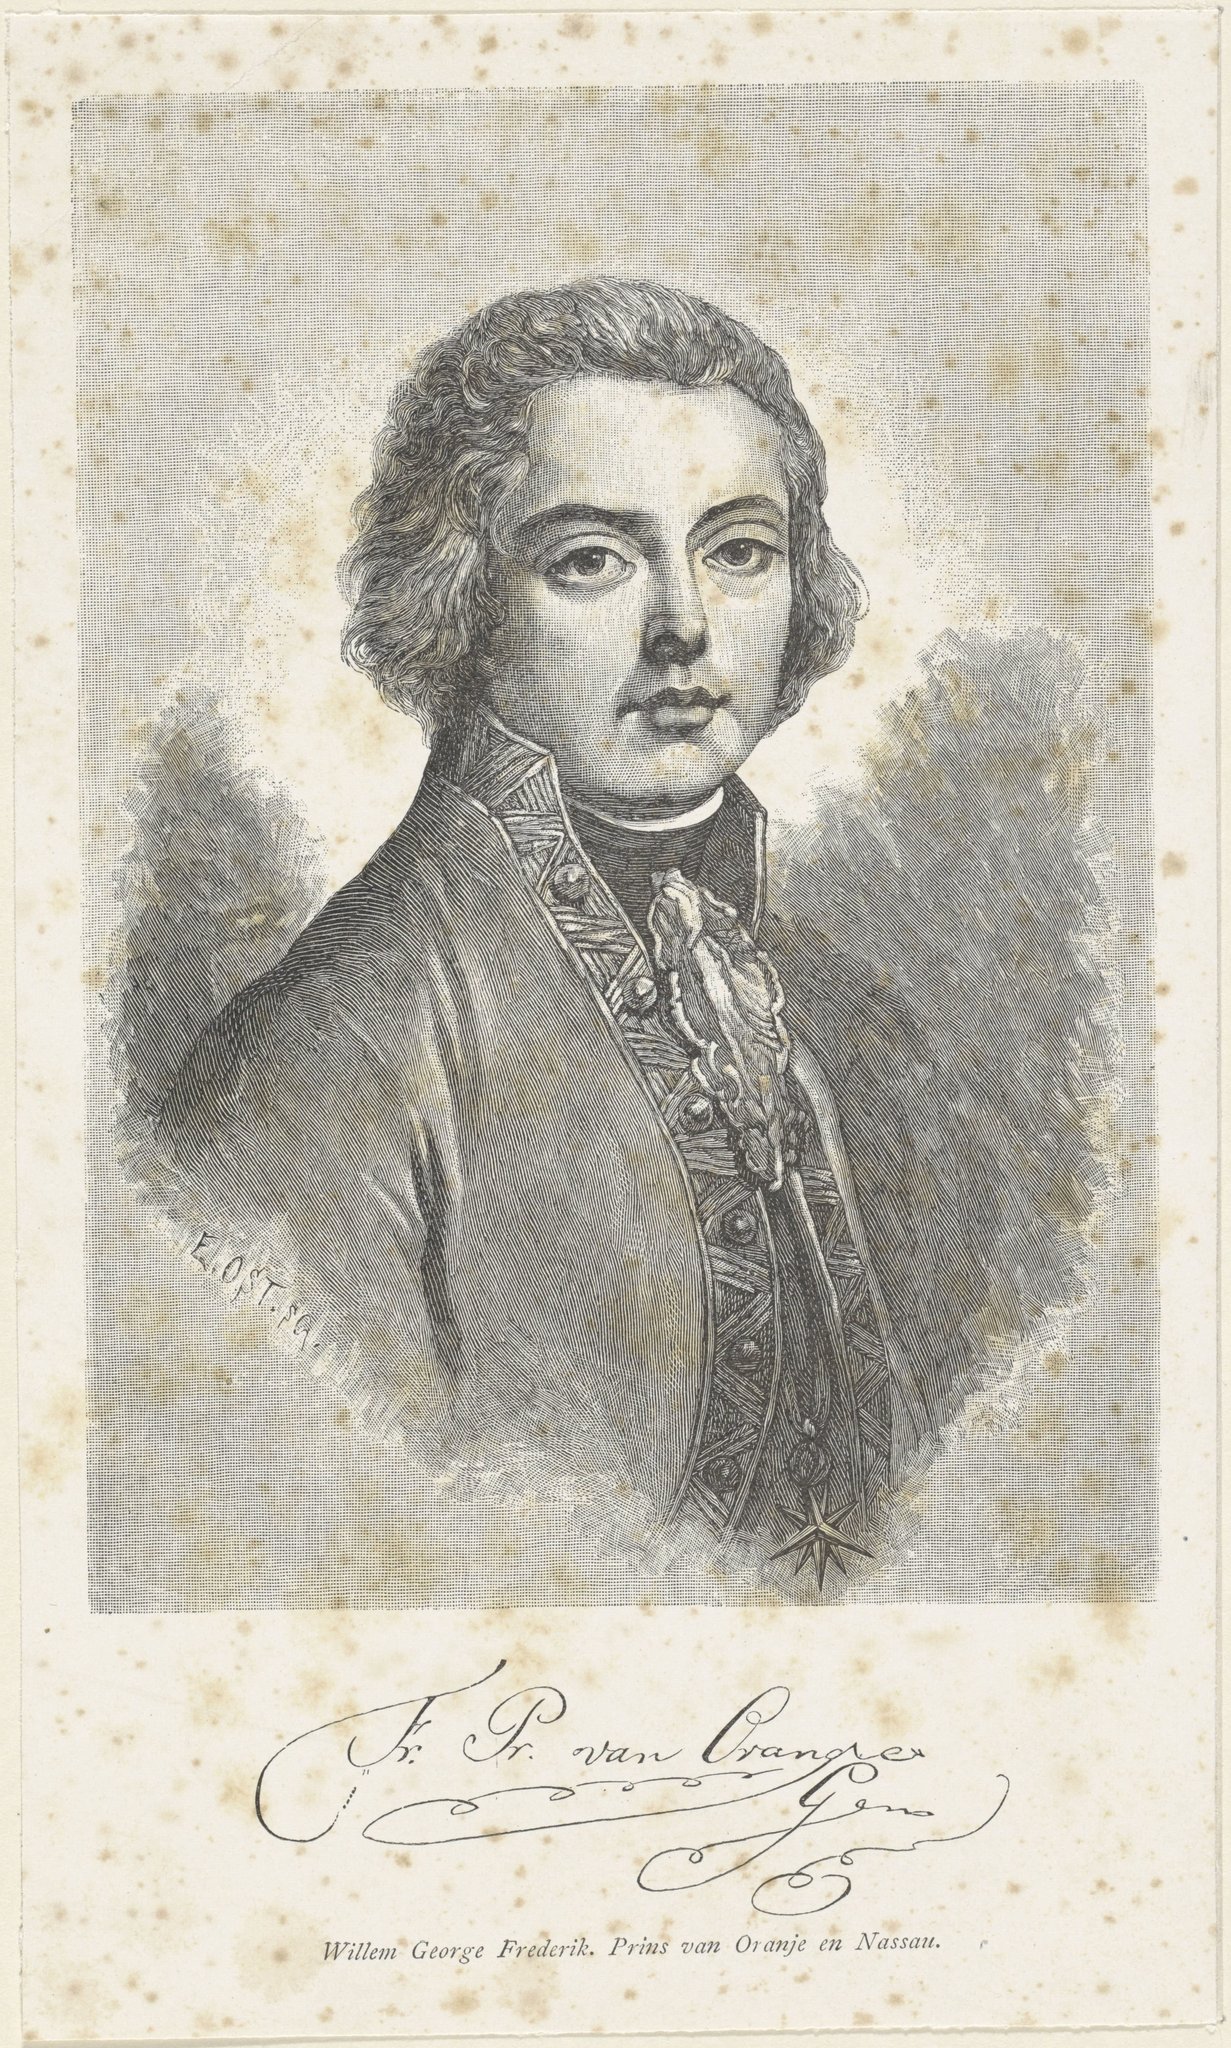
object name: print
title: Portret van Frederik, prins van Oranje-Nassau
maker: emil ost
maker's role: print maker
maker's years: 1846-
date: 1861-1931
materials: paper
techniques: letterpress printing, engraving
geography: belgium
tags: the hague, willem george frederik (prins van oranje-nassau)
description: De hier vermelde titel verwijst naar de hoogst verkregen titel van de geportretteerde, niet per se naar de titel die de geportretteerde op deze voorstelling draagt.